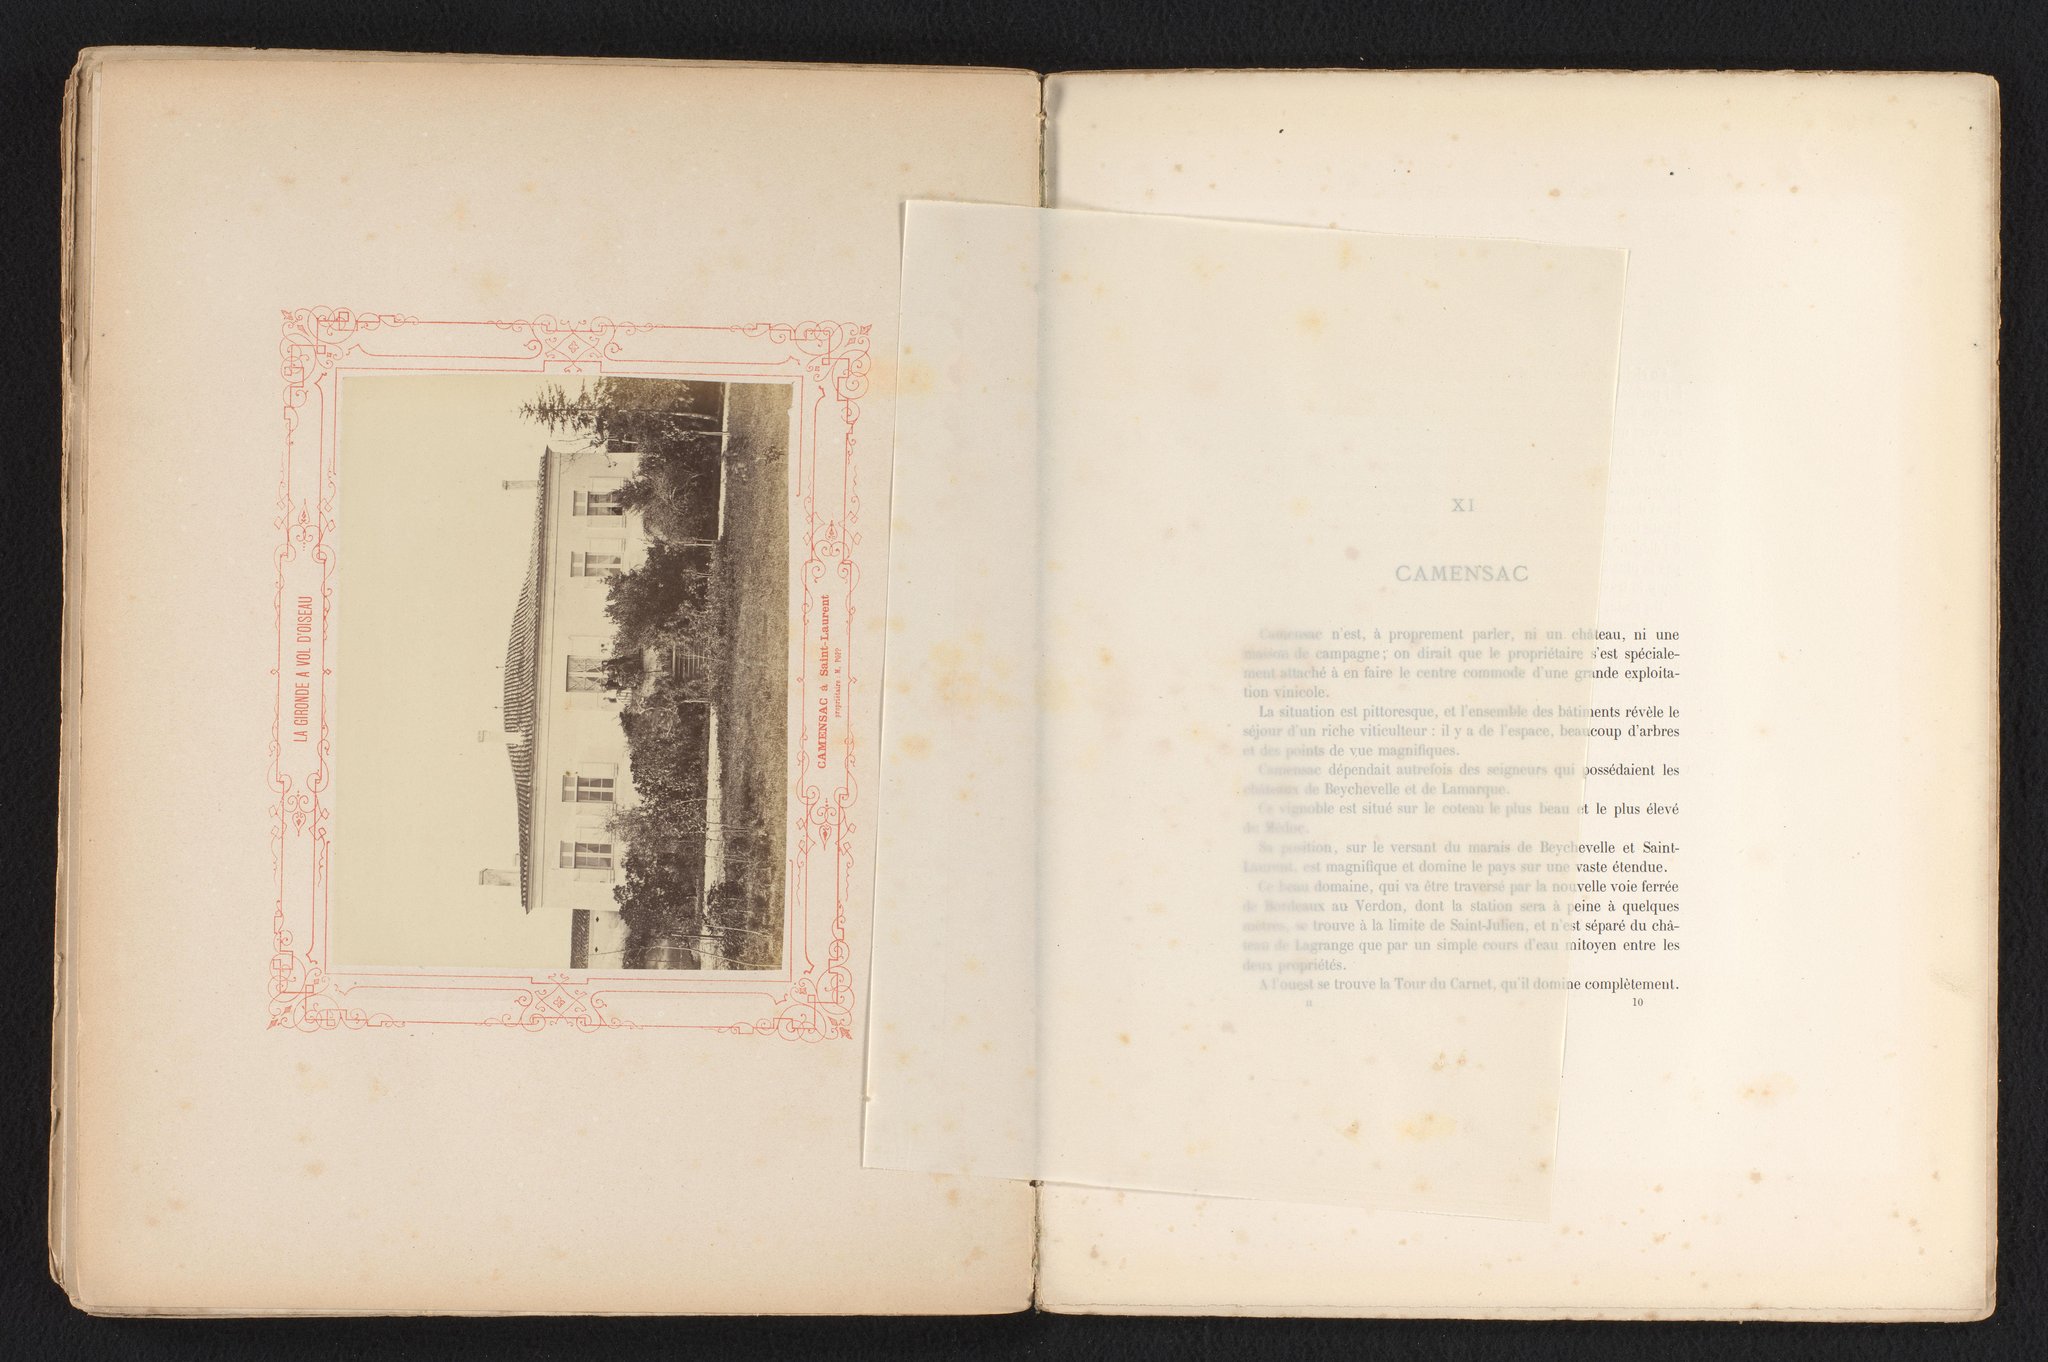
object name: page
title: La Gironde à Vol d'Oiseau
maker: alfred danflou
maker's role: fotograaf, schrijver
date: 1862-1867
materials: paper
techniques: albumen print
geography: saint-laurent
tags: castle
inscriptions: inscription: ‘propriétaire: M. POPP.’